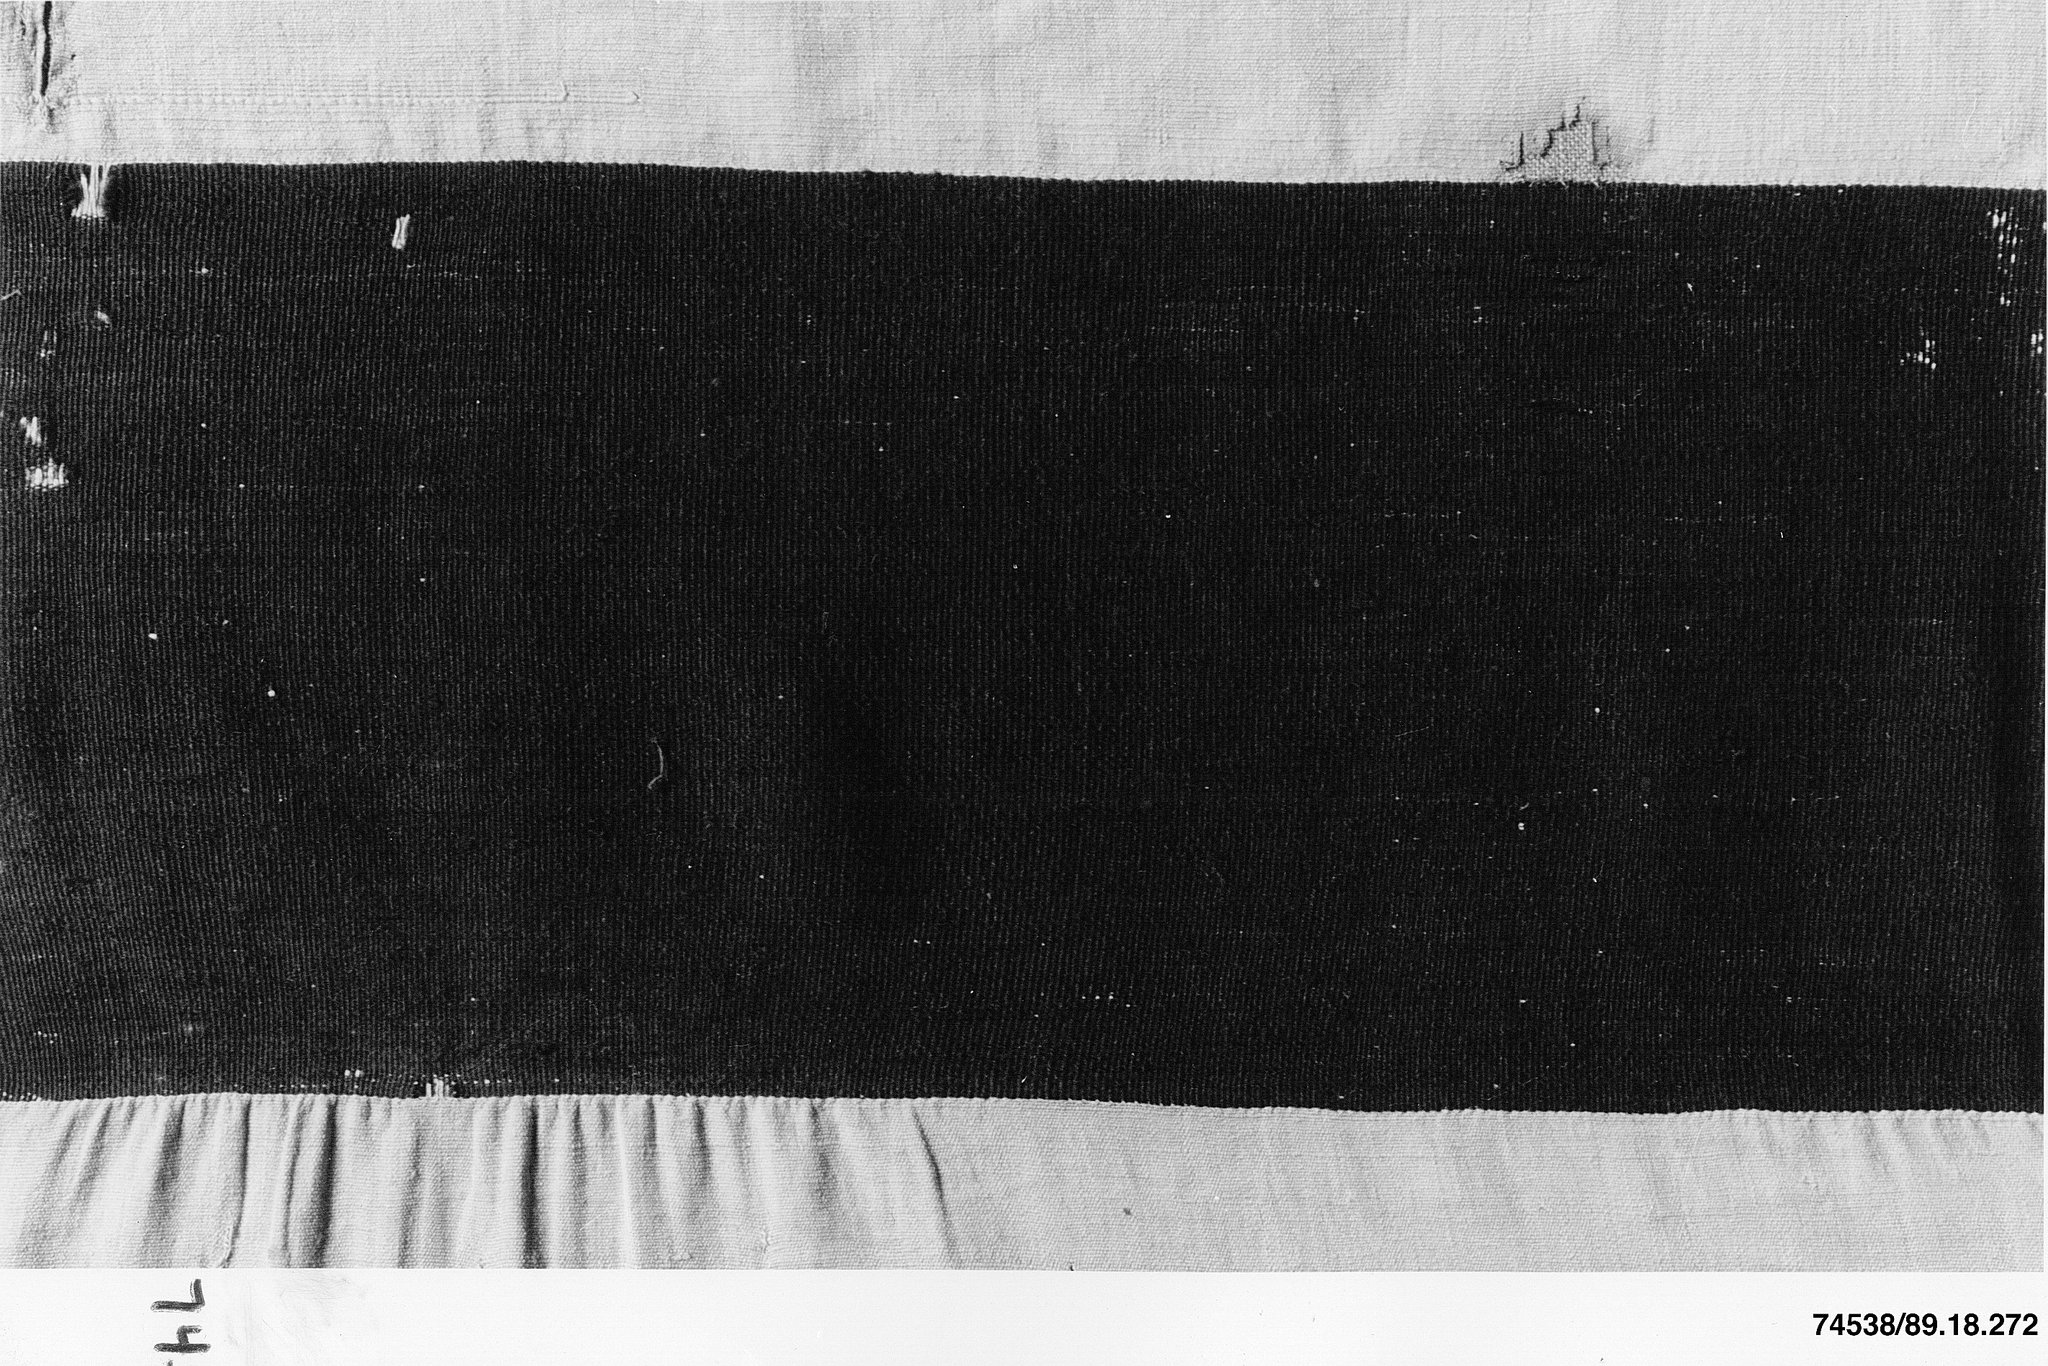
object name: textile fragment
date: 201-400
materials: linen, wool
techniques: weave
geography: egypt